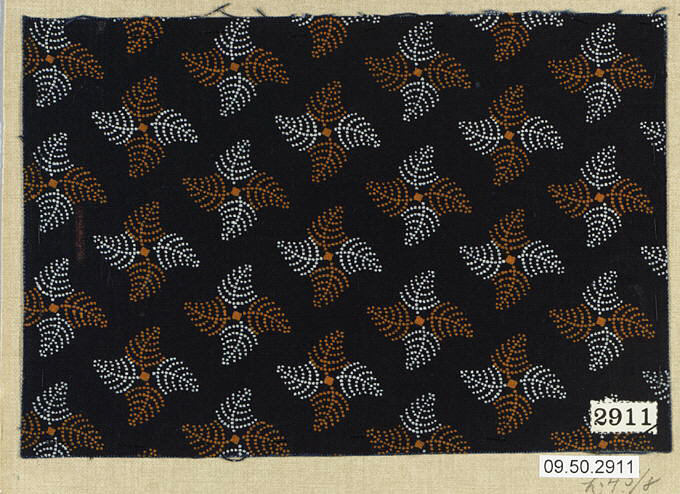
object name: piece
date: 1801-1900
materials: cotton